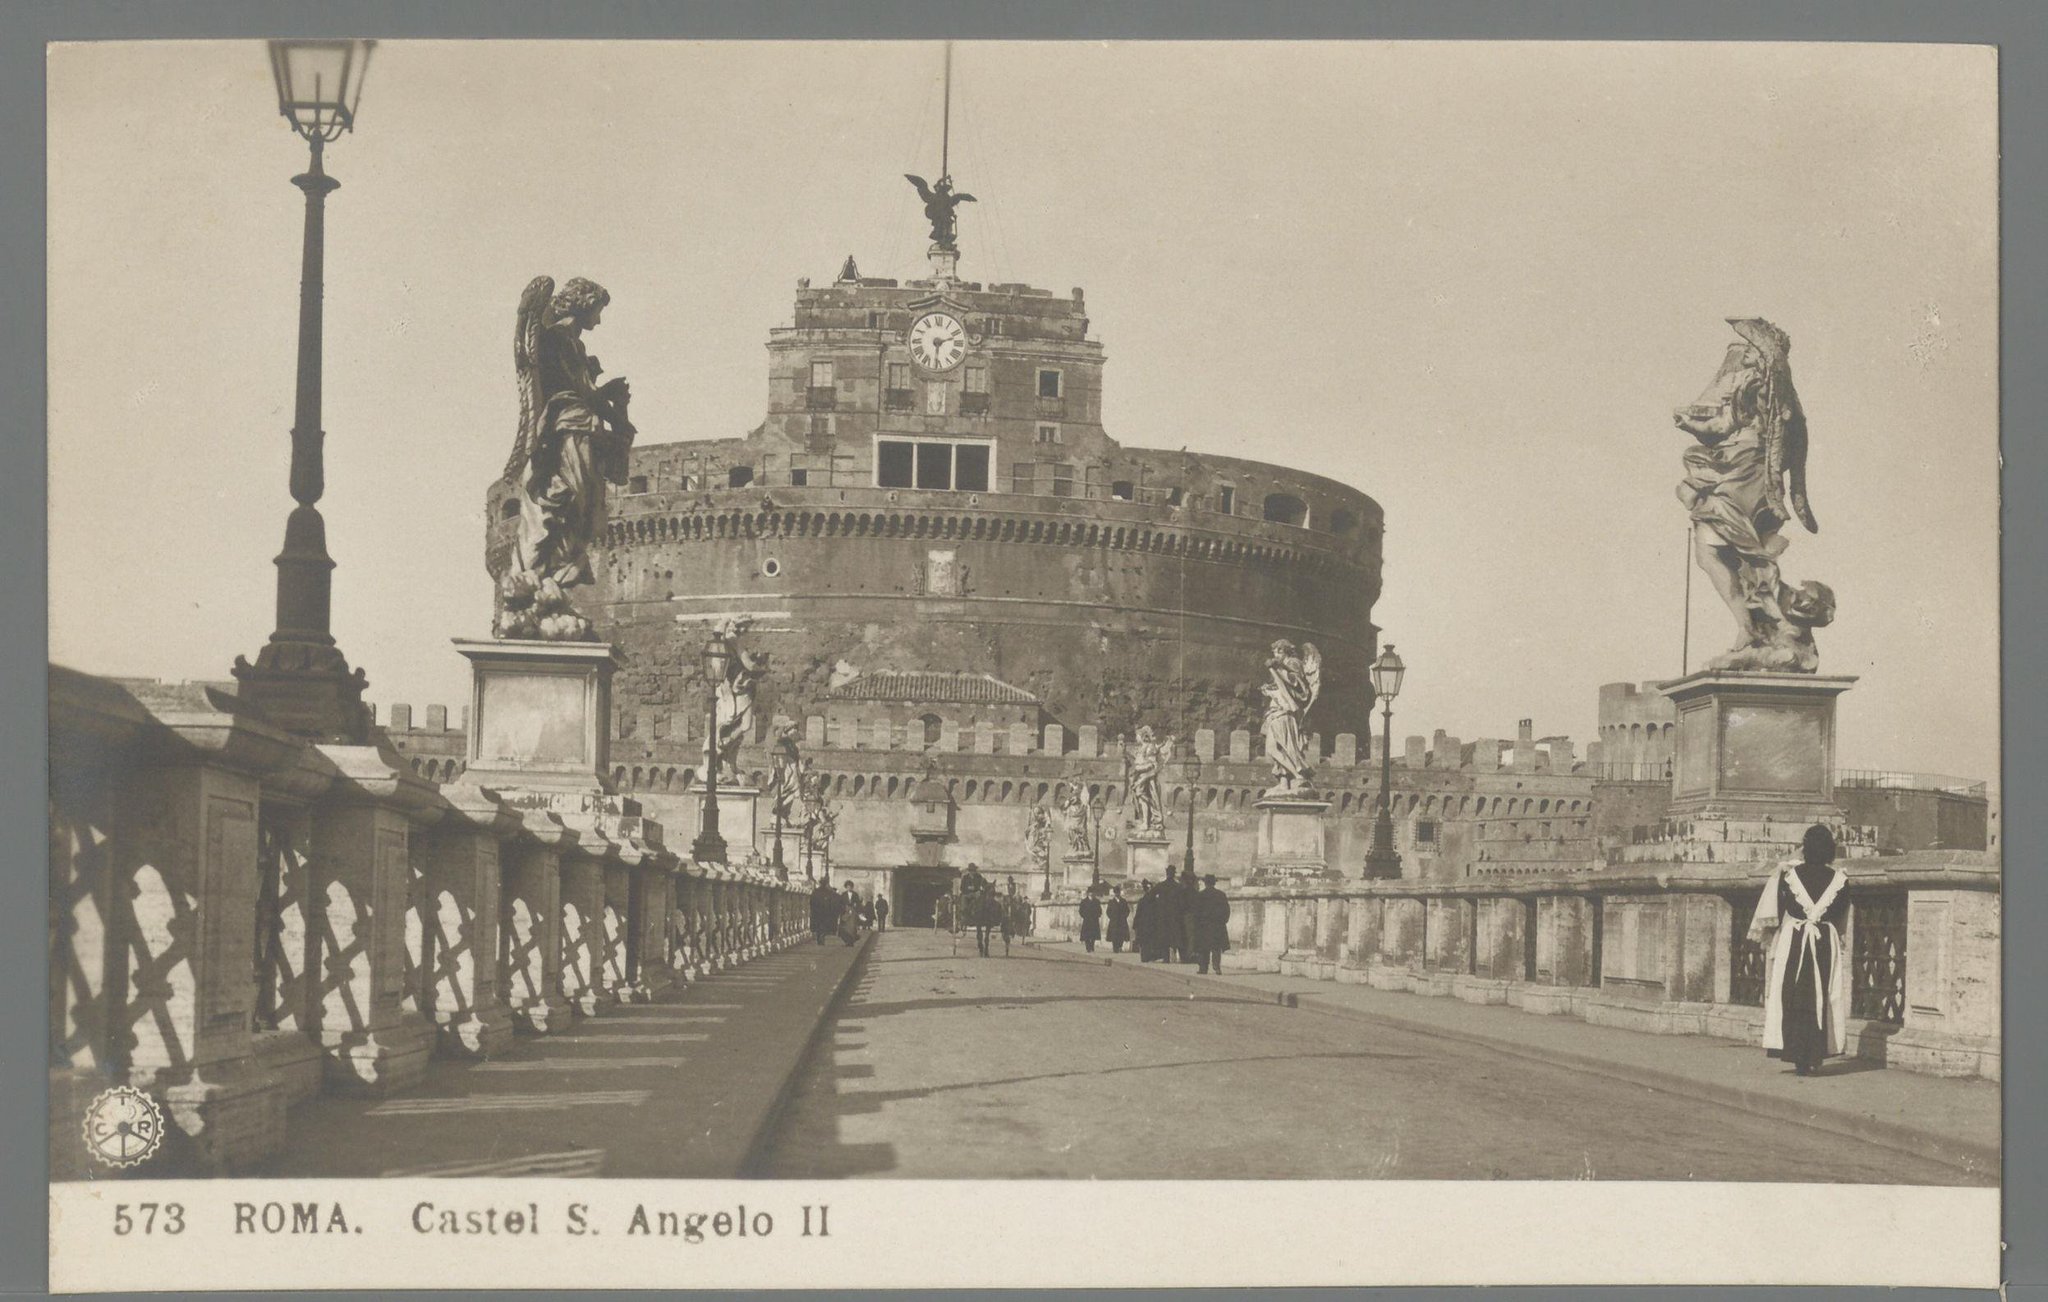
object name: photograph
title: Roma. Castel S. Angelo II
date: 1906-1920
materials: photographic support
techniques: photography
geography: rome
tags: fortress, bridge